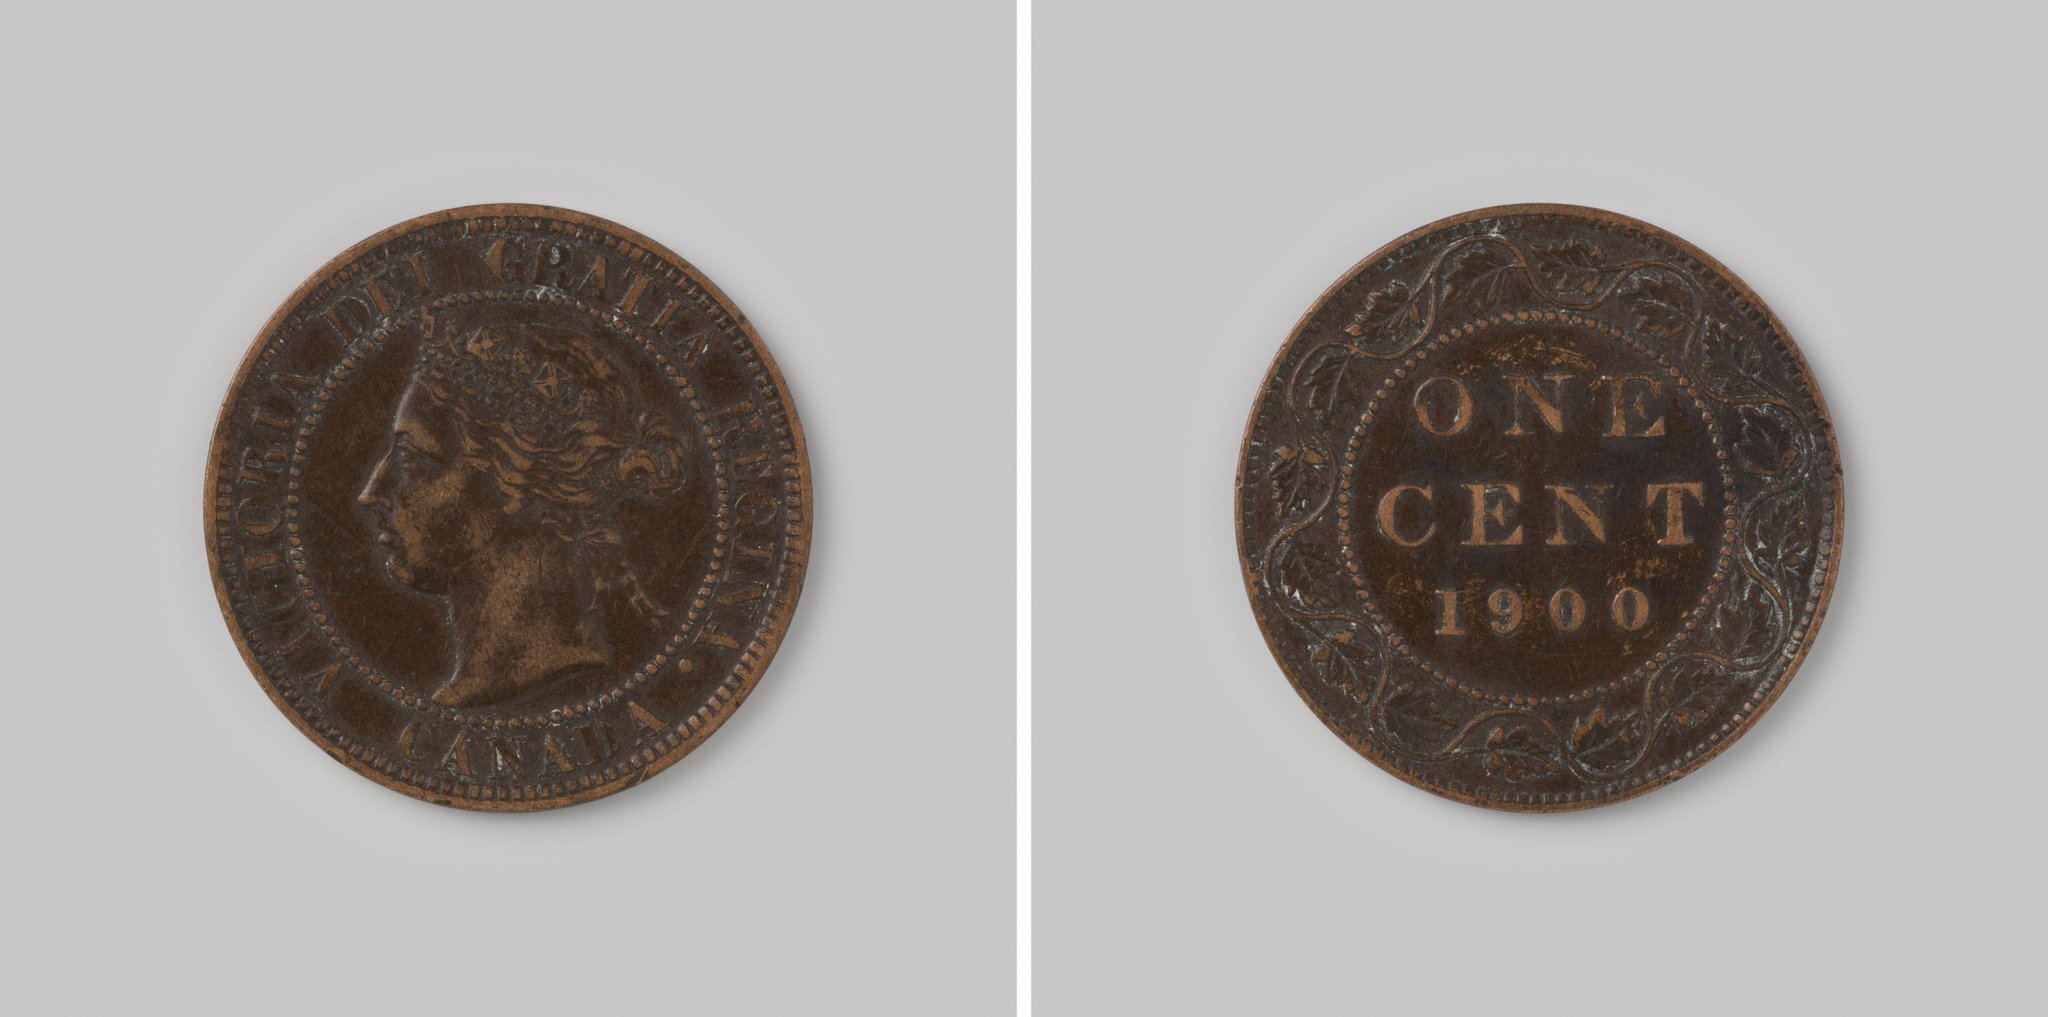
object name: coin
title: Canada, cent, 1900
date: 1900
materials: bronze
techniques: striking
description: Bronzen munt. Voorzijde: gekroond hoofd van vorstin Victoria naar links. Daaronder lands-aanduiding. Keerzxijde: binnen een kring van bladeren in twee regels waarde-aanduiding, waaronder jaartal. Gladde rand.